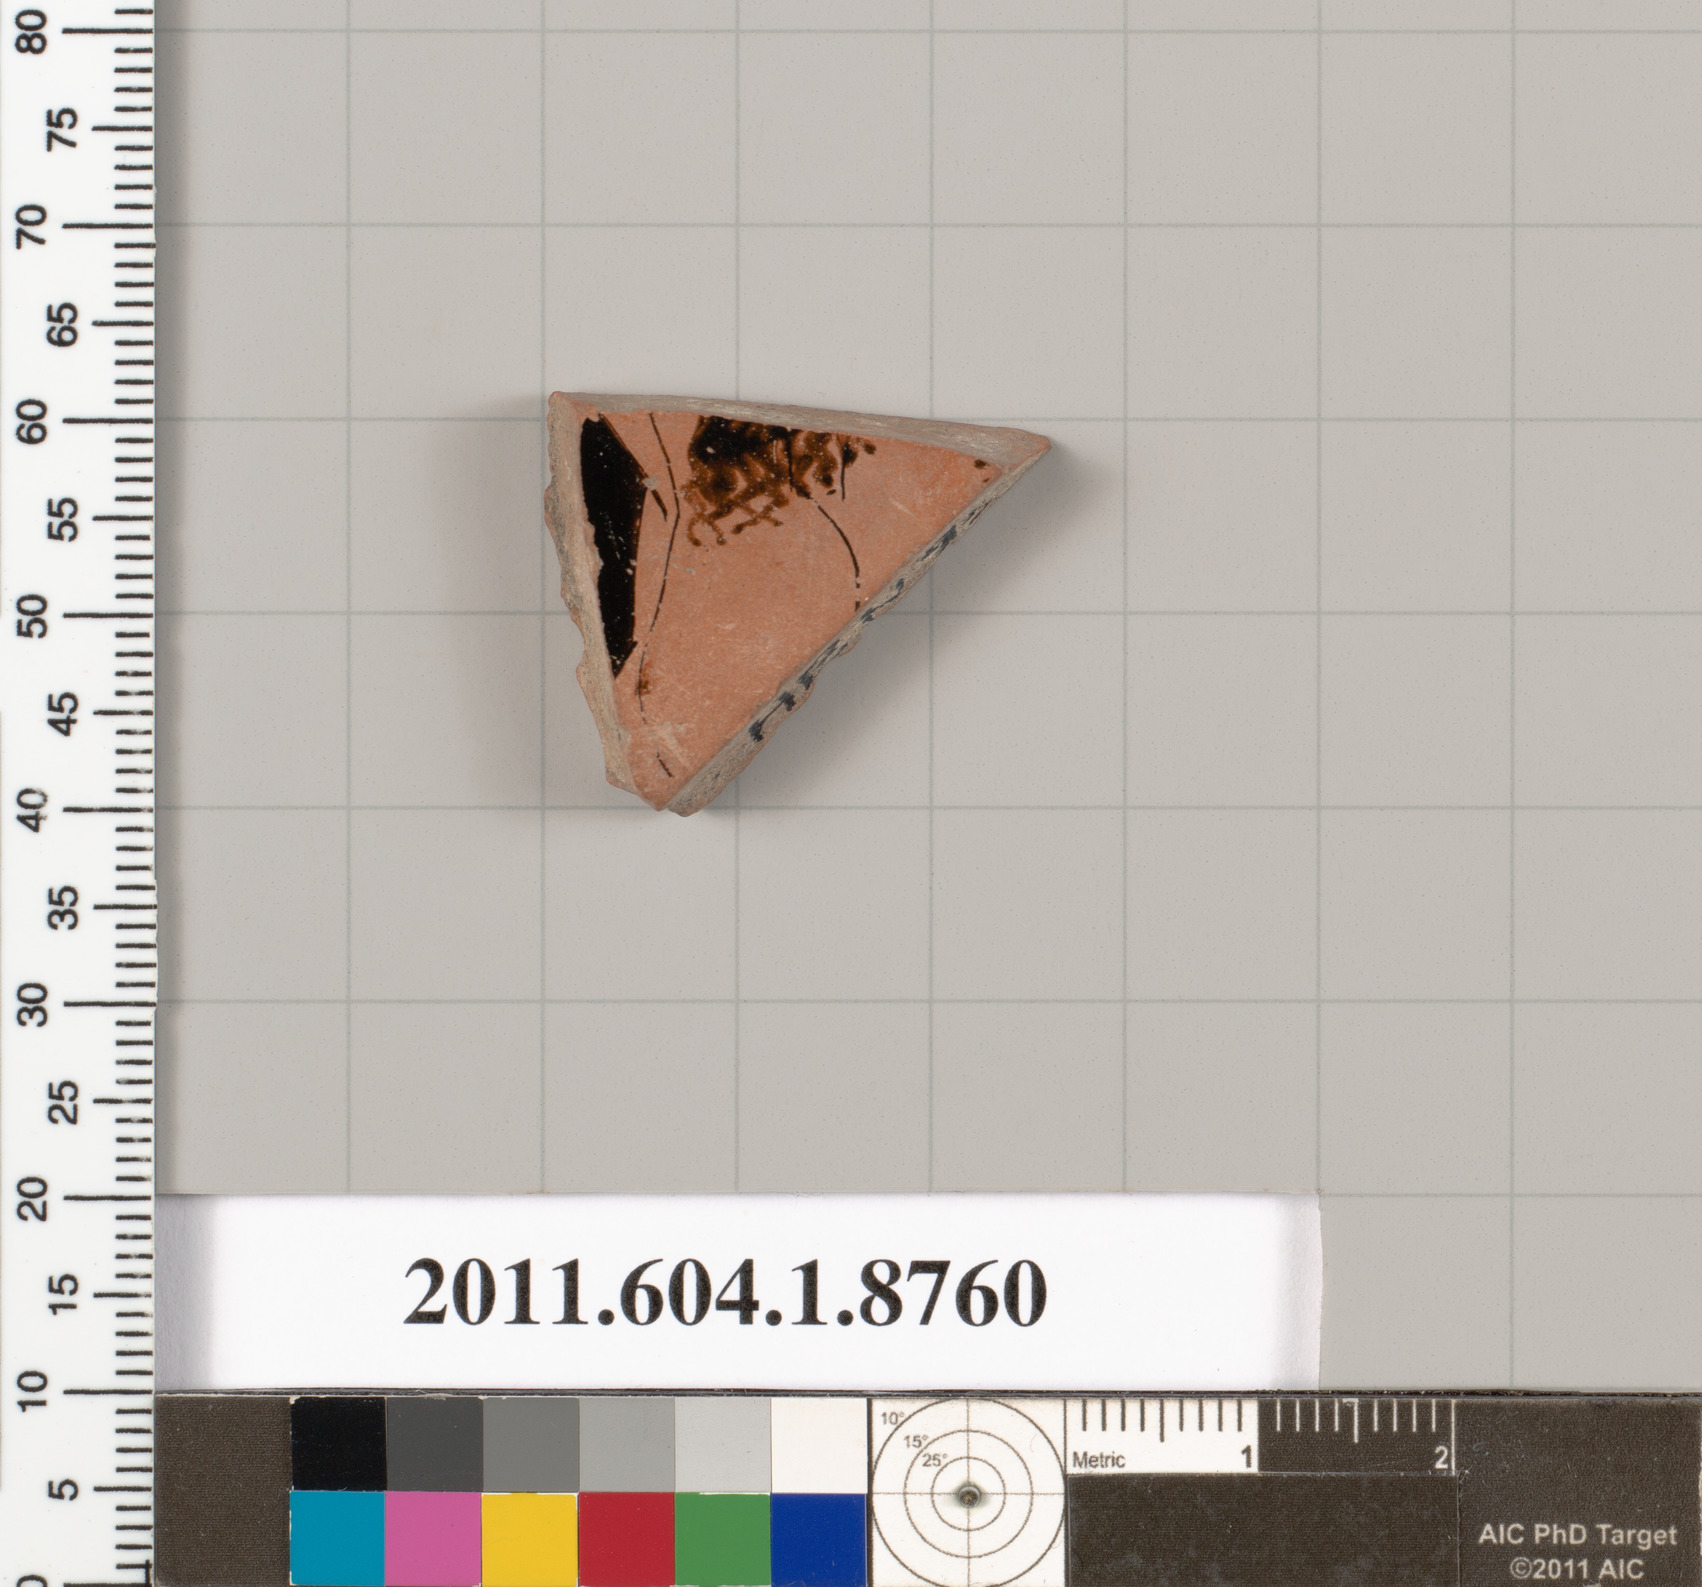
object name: kylix fragment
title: Terracotta fragment of a kylix (drinking cup)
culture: greek, attic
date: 475-451 BCE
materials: terracotta